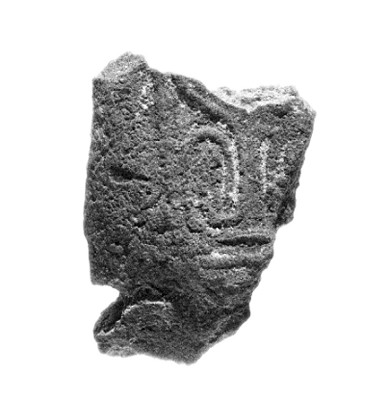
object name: sealing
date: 1981-1640 BCE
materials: mud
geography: egypt